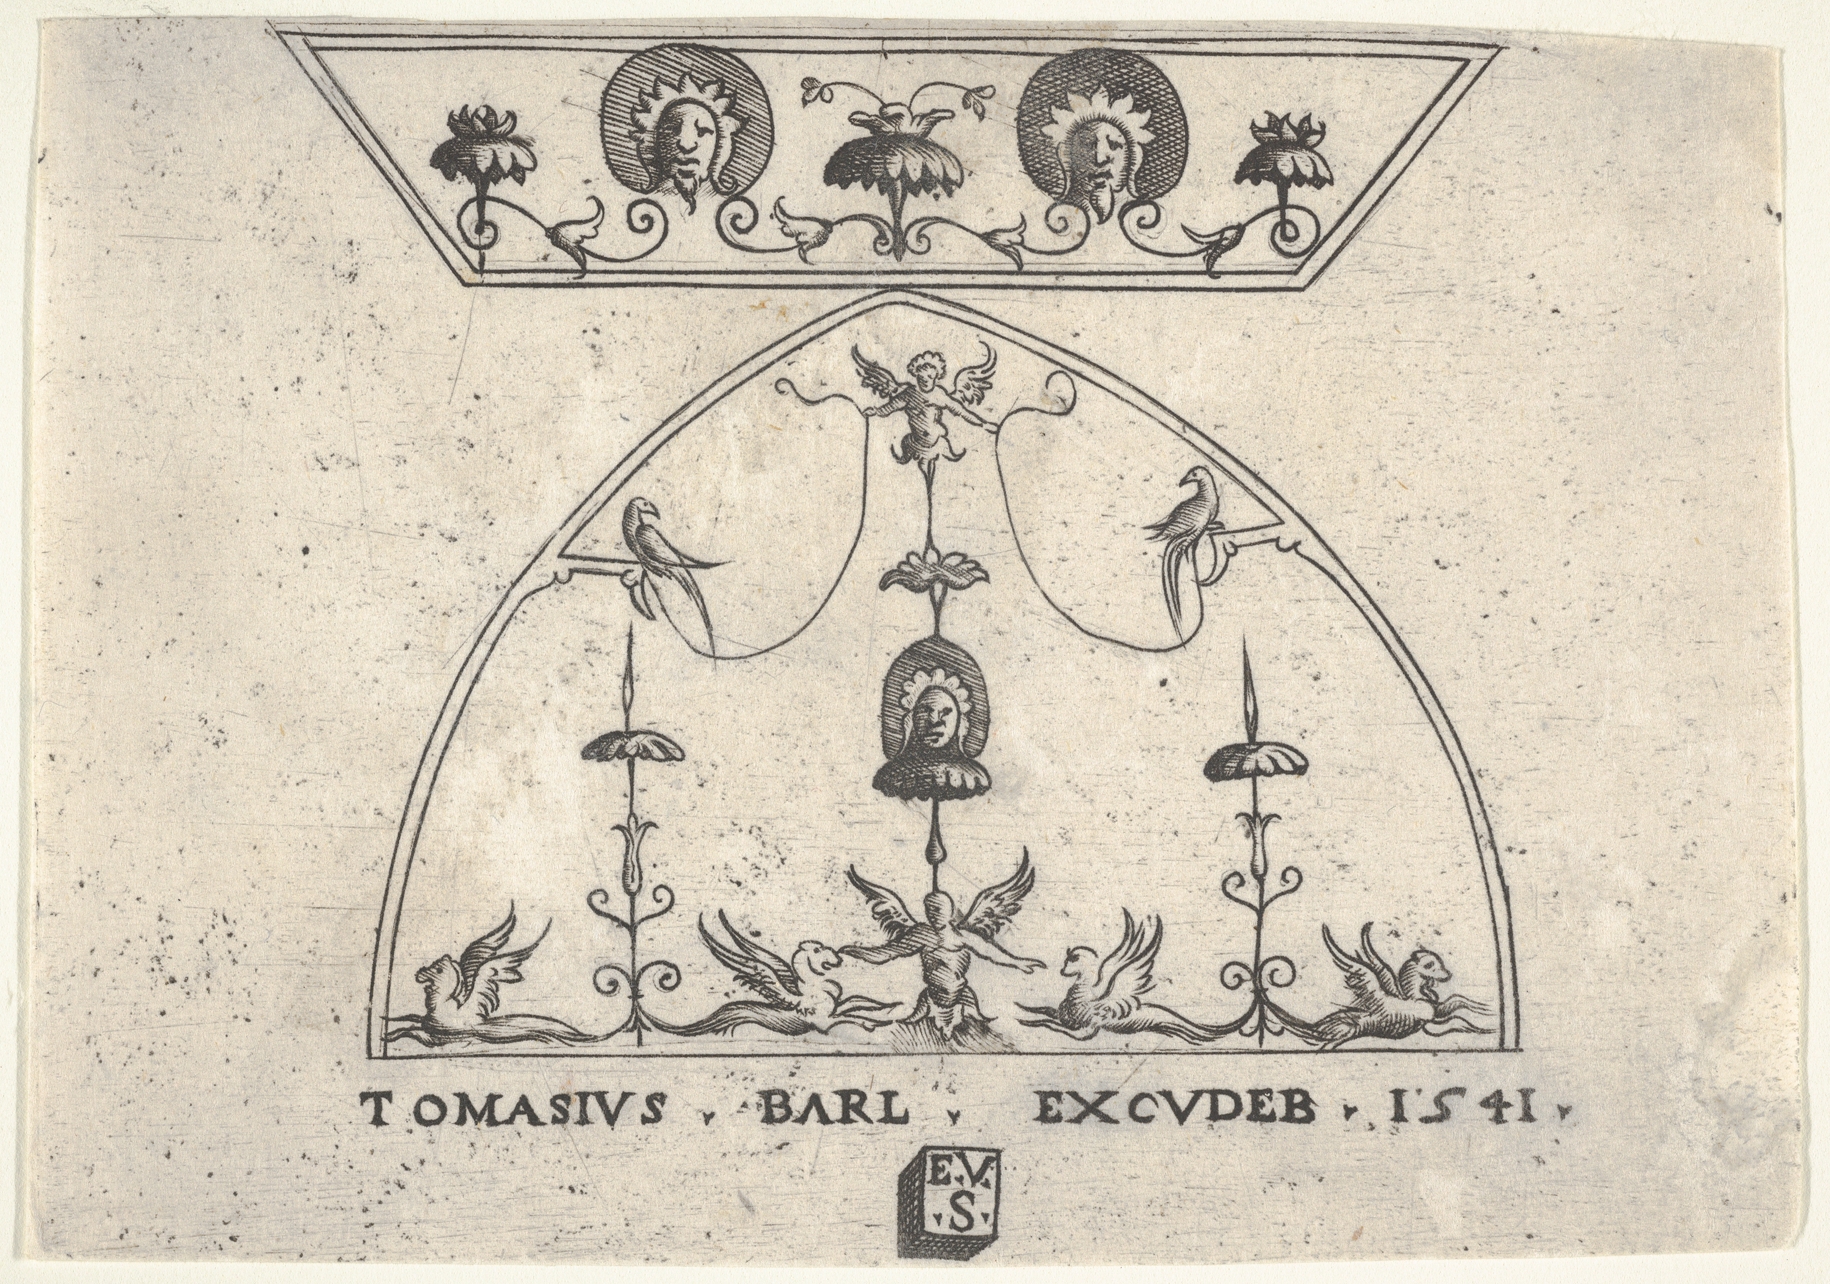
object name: print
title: Two panels of grotesque decoration, with winged human figures, birds, and griffins, from a series of panels of different dimensions representing grotesques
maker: enea vico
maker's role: artist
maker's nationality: italian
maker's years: 1523-1567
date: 1541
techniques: engraving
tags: birds,griffins